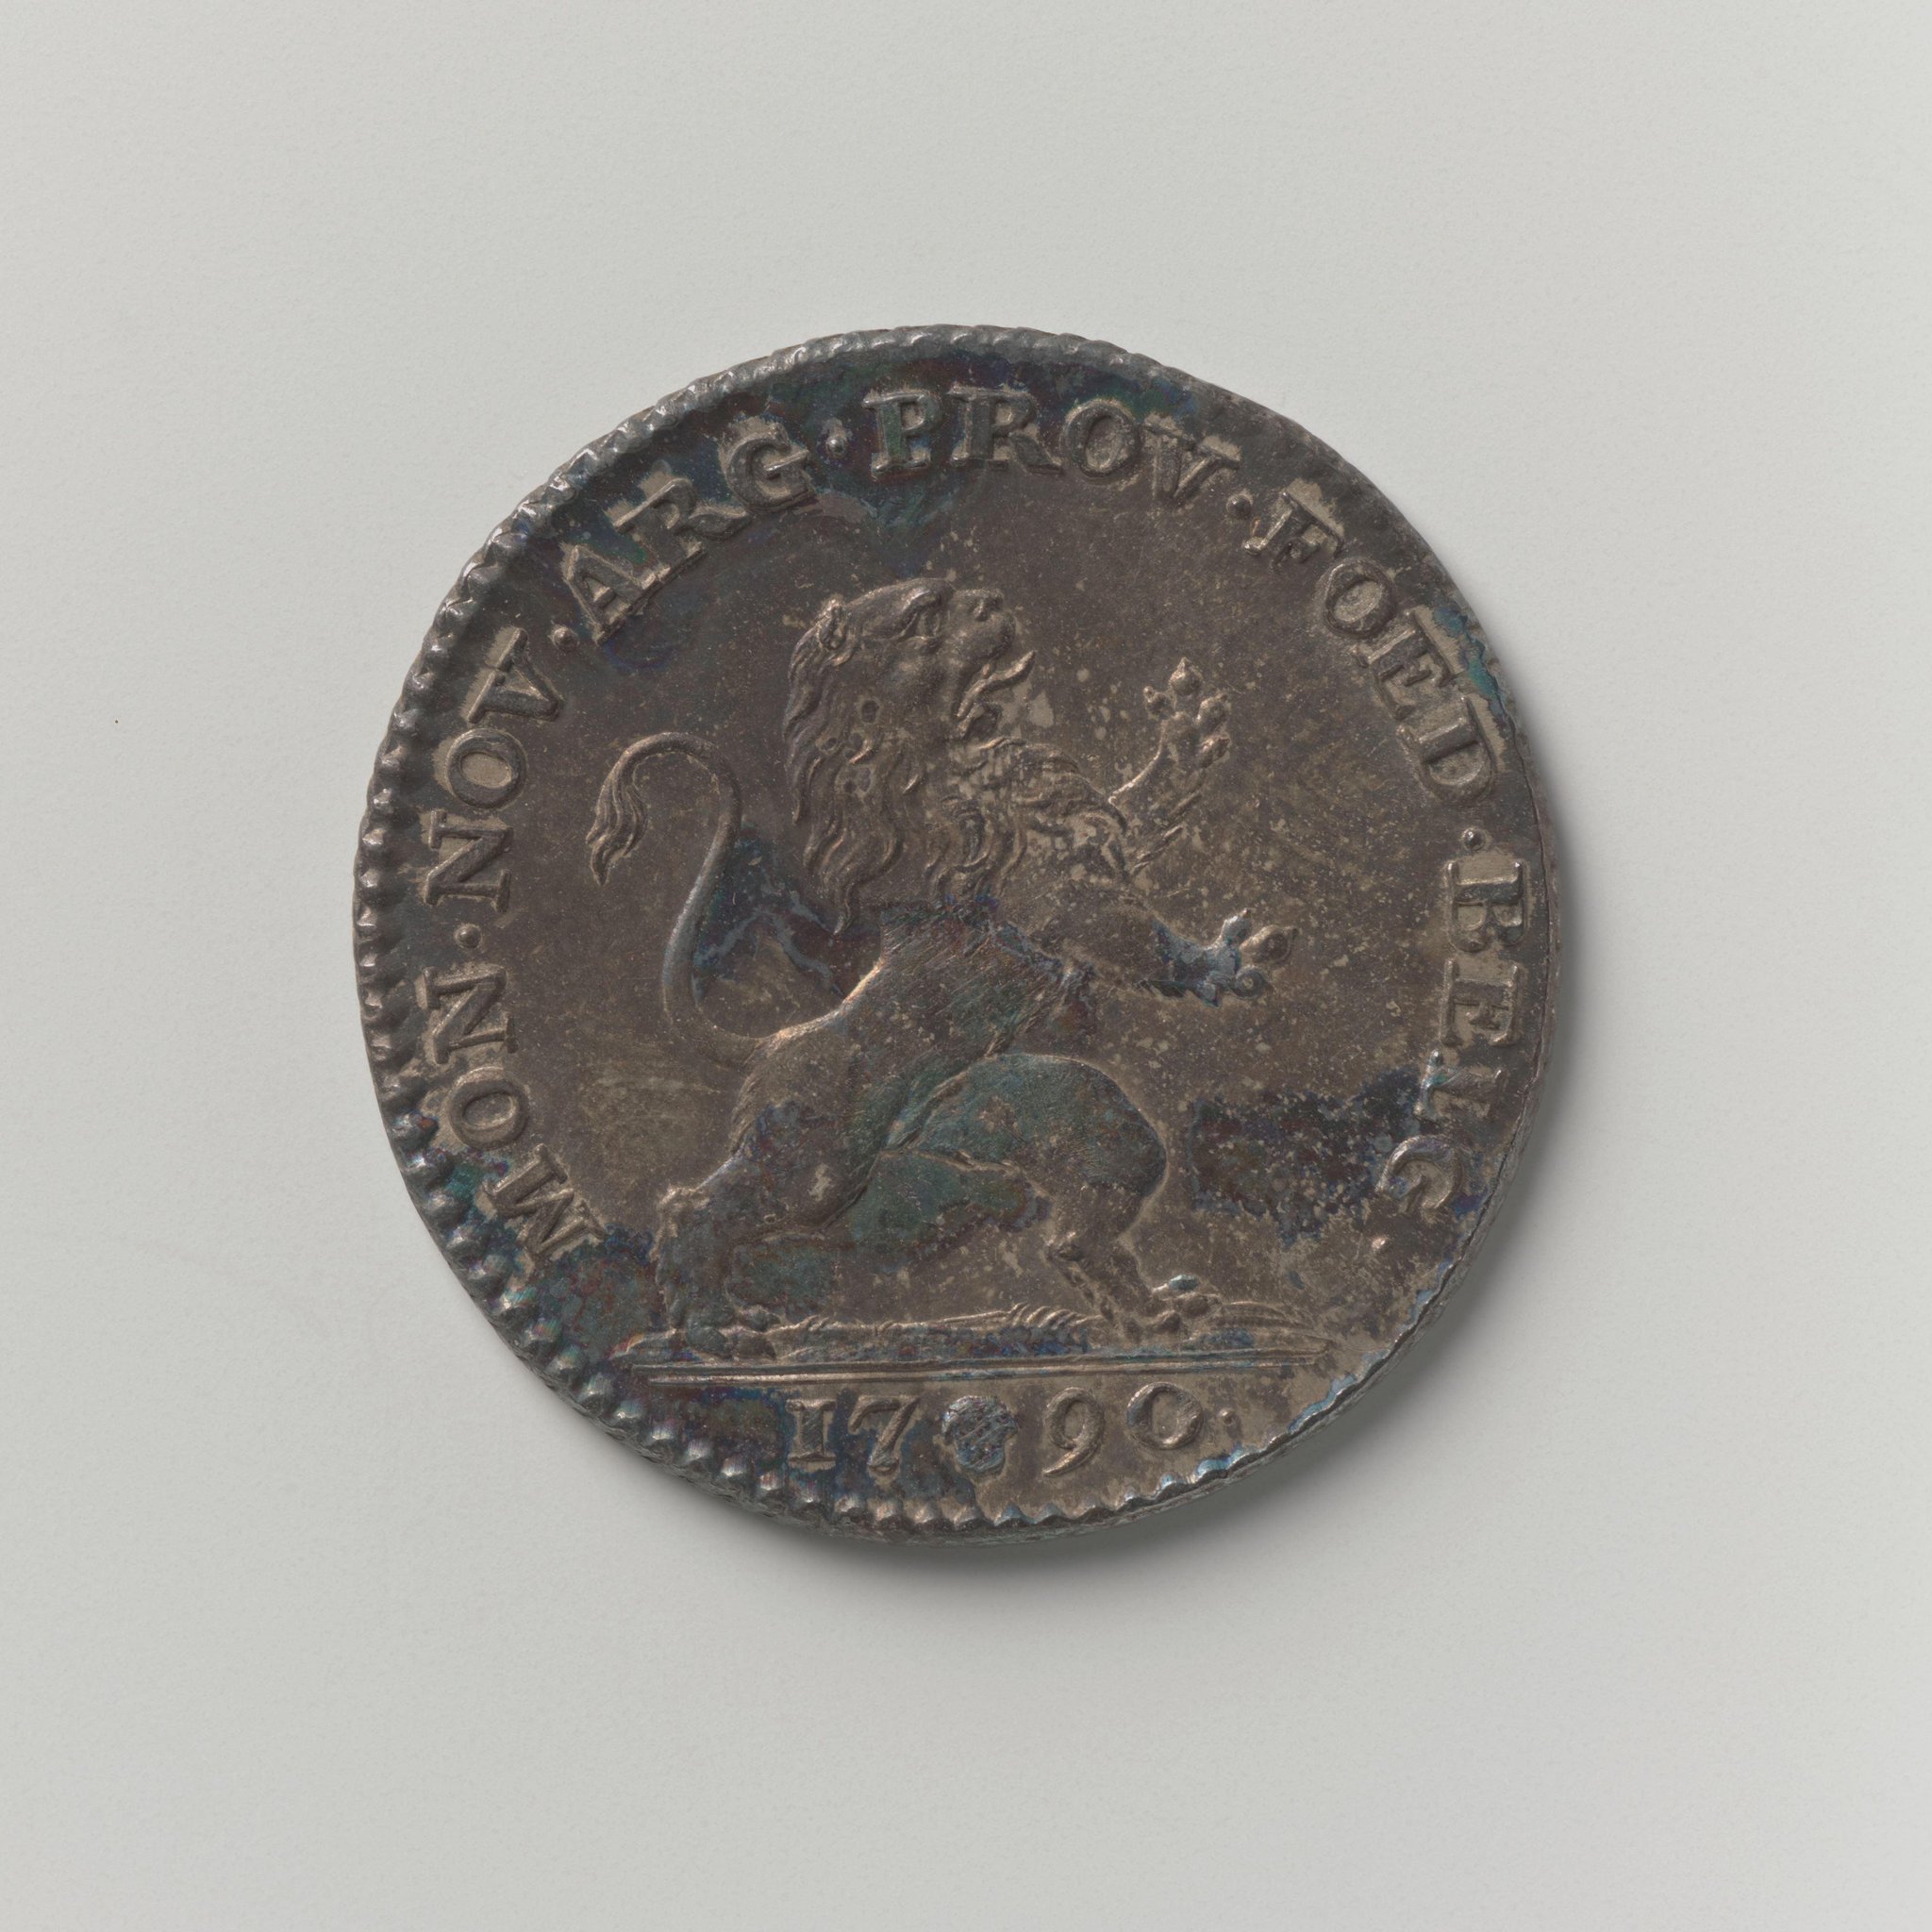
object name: coin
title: Gulden van de Verenigde Belgische Staten, 1790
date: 1790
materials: silver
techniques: striking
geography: brussels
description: Zilveren munt. Voorzijde: staande leeuw naar rechts. Jaartal, waartussen engelenkop, in afsnede. Keerzijde: twee uit wolken komende ineengeslagen handen, waarin pijlenbundel. In afsnede waarde-aanduiding. Omschrift: IN VNIONE SALVS. Kabelrand.